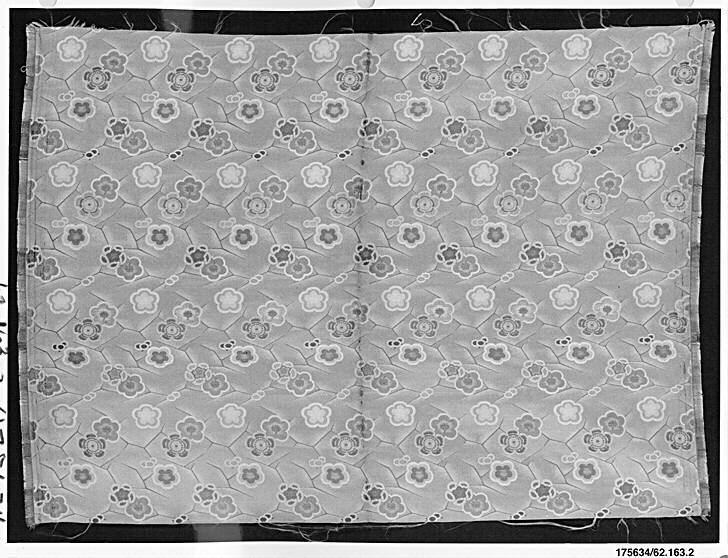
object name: piece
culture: japanese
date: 1701-1800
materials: metal thread, silk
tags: flowers